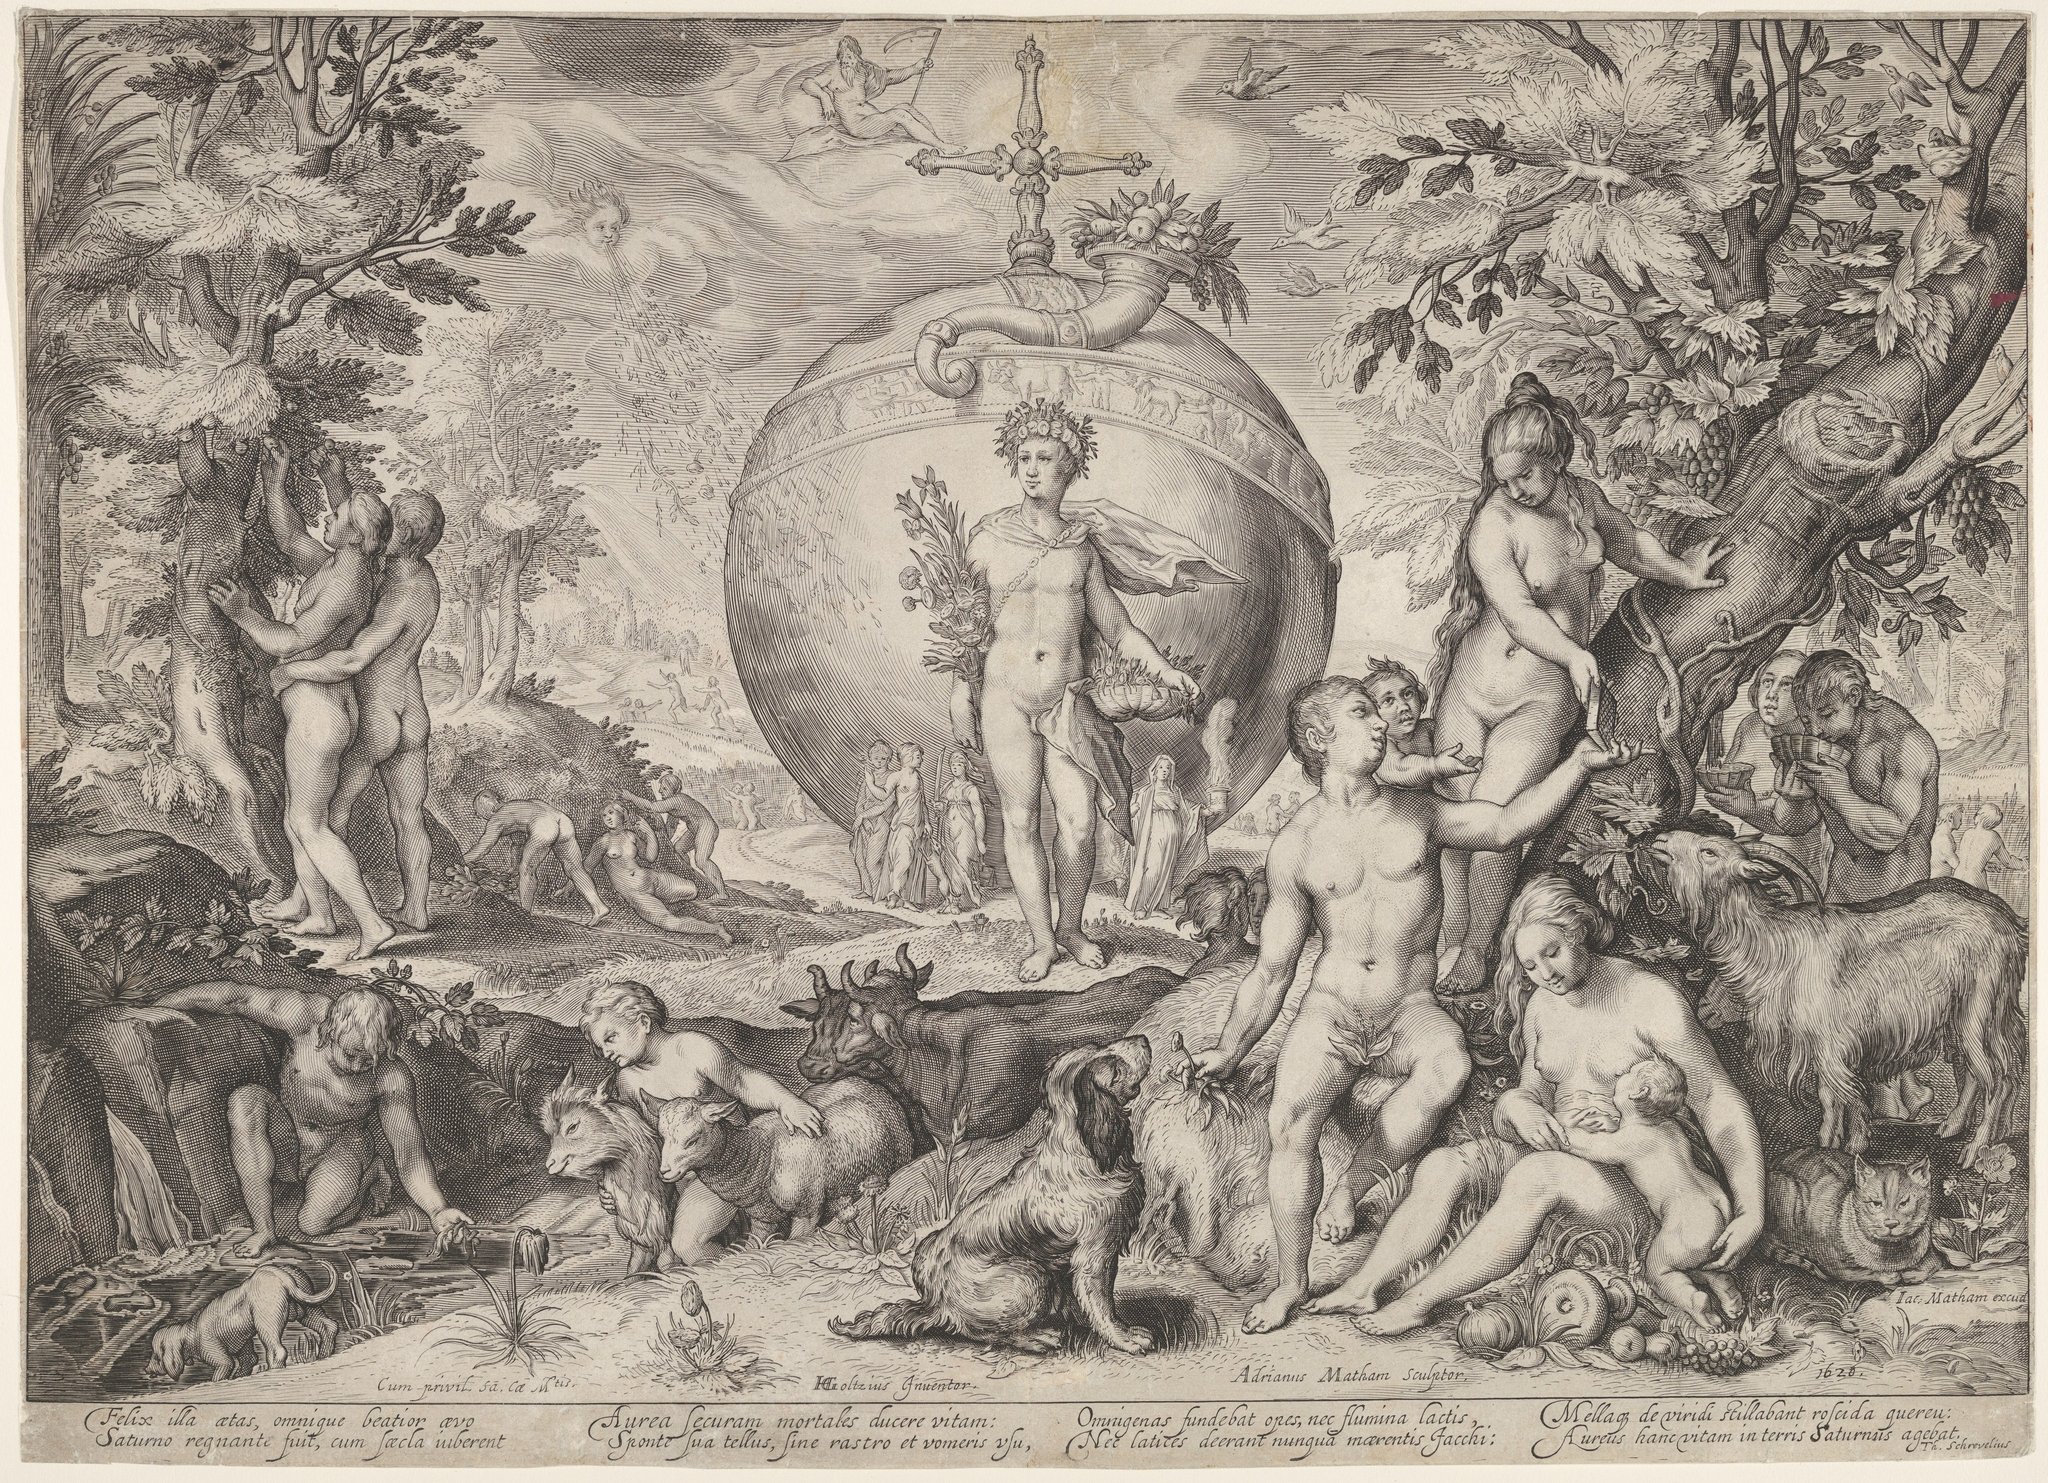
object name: print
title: The Golden Age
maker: adriaen matham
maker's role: artist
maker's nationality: dutch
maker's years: 1599-1660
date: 1620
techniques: engraving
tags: infants,male nudes,female nudes,cows,dogs,goats